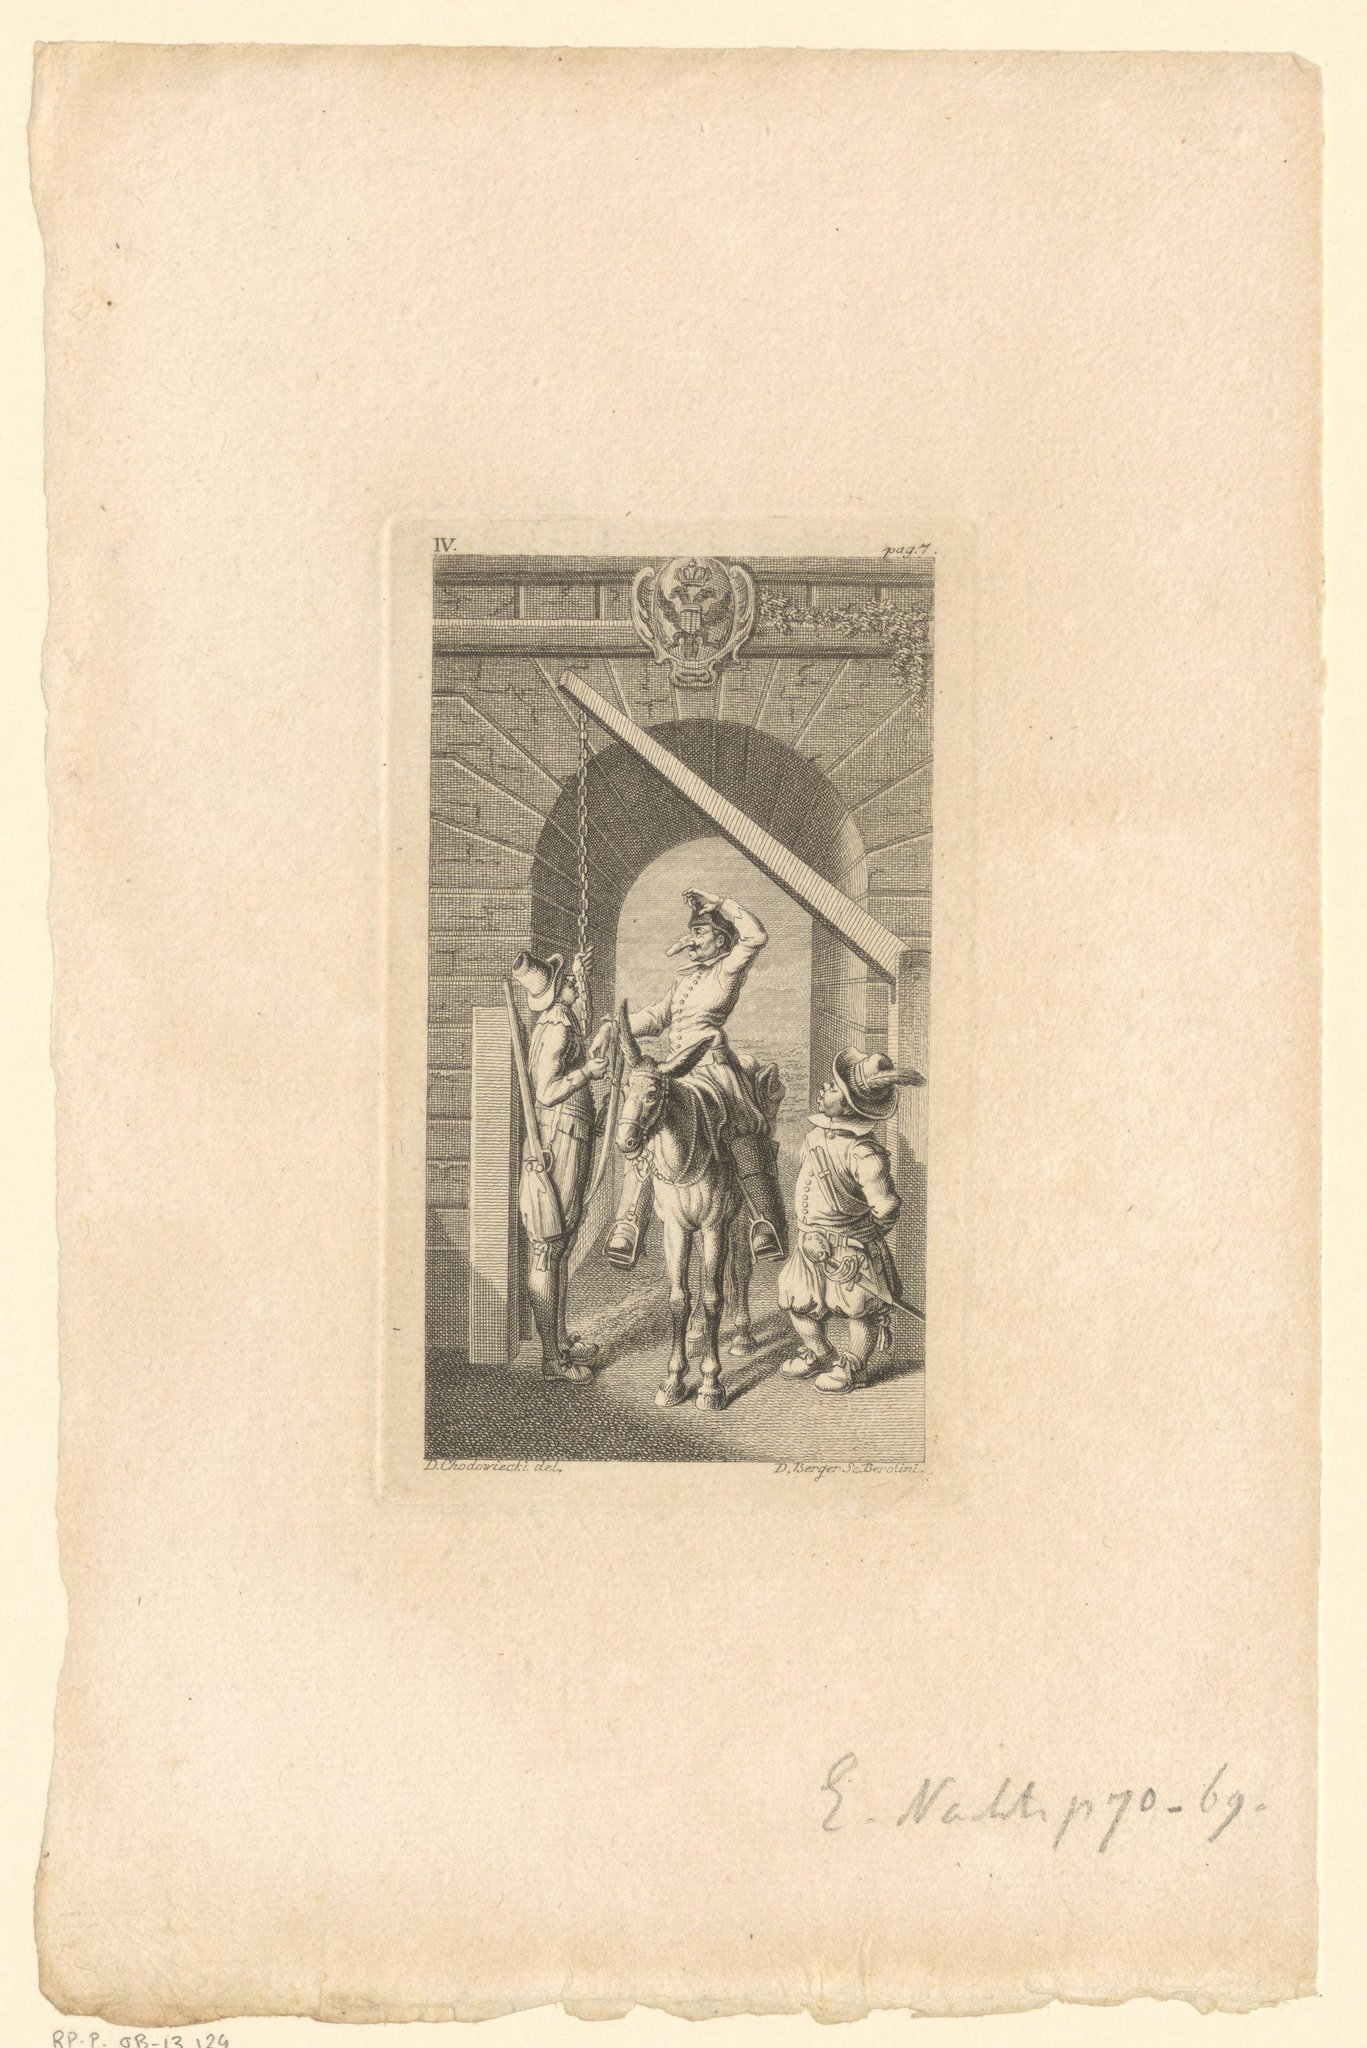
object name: print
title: Man met een grote neus rijdt de stadspoort van Straatsburg binnen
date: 1778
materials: paper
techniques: etching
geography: berlin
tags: clergyman, riding a horse, ass, or mule; rider, horseman, literary characters and objects, parts of the face: nose, city-gate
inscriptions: collector's mark: Lugt 240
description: Zesde prent uit de serie 'XII Kupfer zu den Leben und Meynungen Tristram Shandy's', bestaand uit een titelpagina en 12 prenten, gedrukt op kosten van de Berlijnse boekhandelaar Christian Friedrich Himburg in 1778. De illustraties volgen een eerder verschenen tekstuitgave: [Stern, Laurence]. Tristram Schandis Leben und Meynungen [uit het Duits vertaald door] Johann Joachim Christoph Bode. 9 dln. Hamburg: Carl Ernst Bohn te Hamburg, 1776.